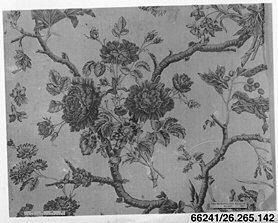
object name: piece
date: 1785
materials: linen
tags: flowers,leaves